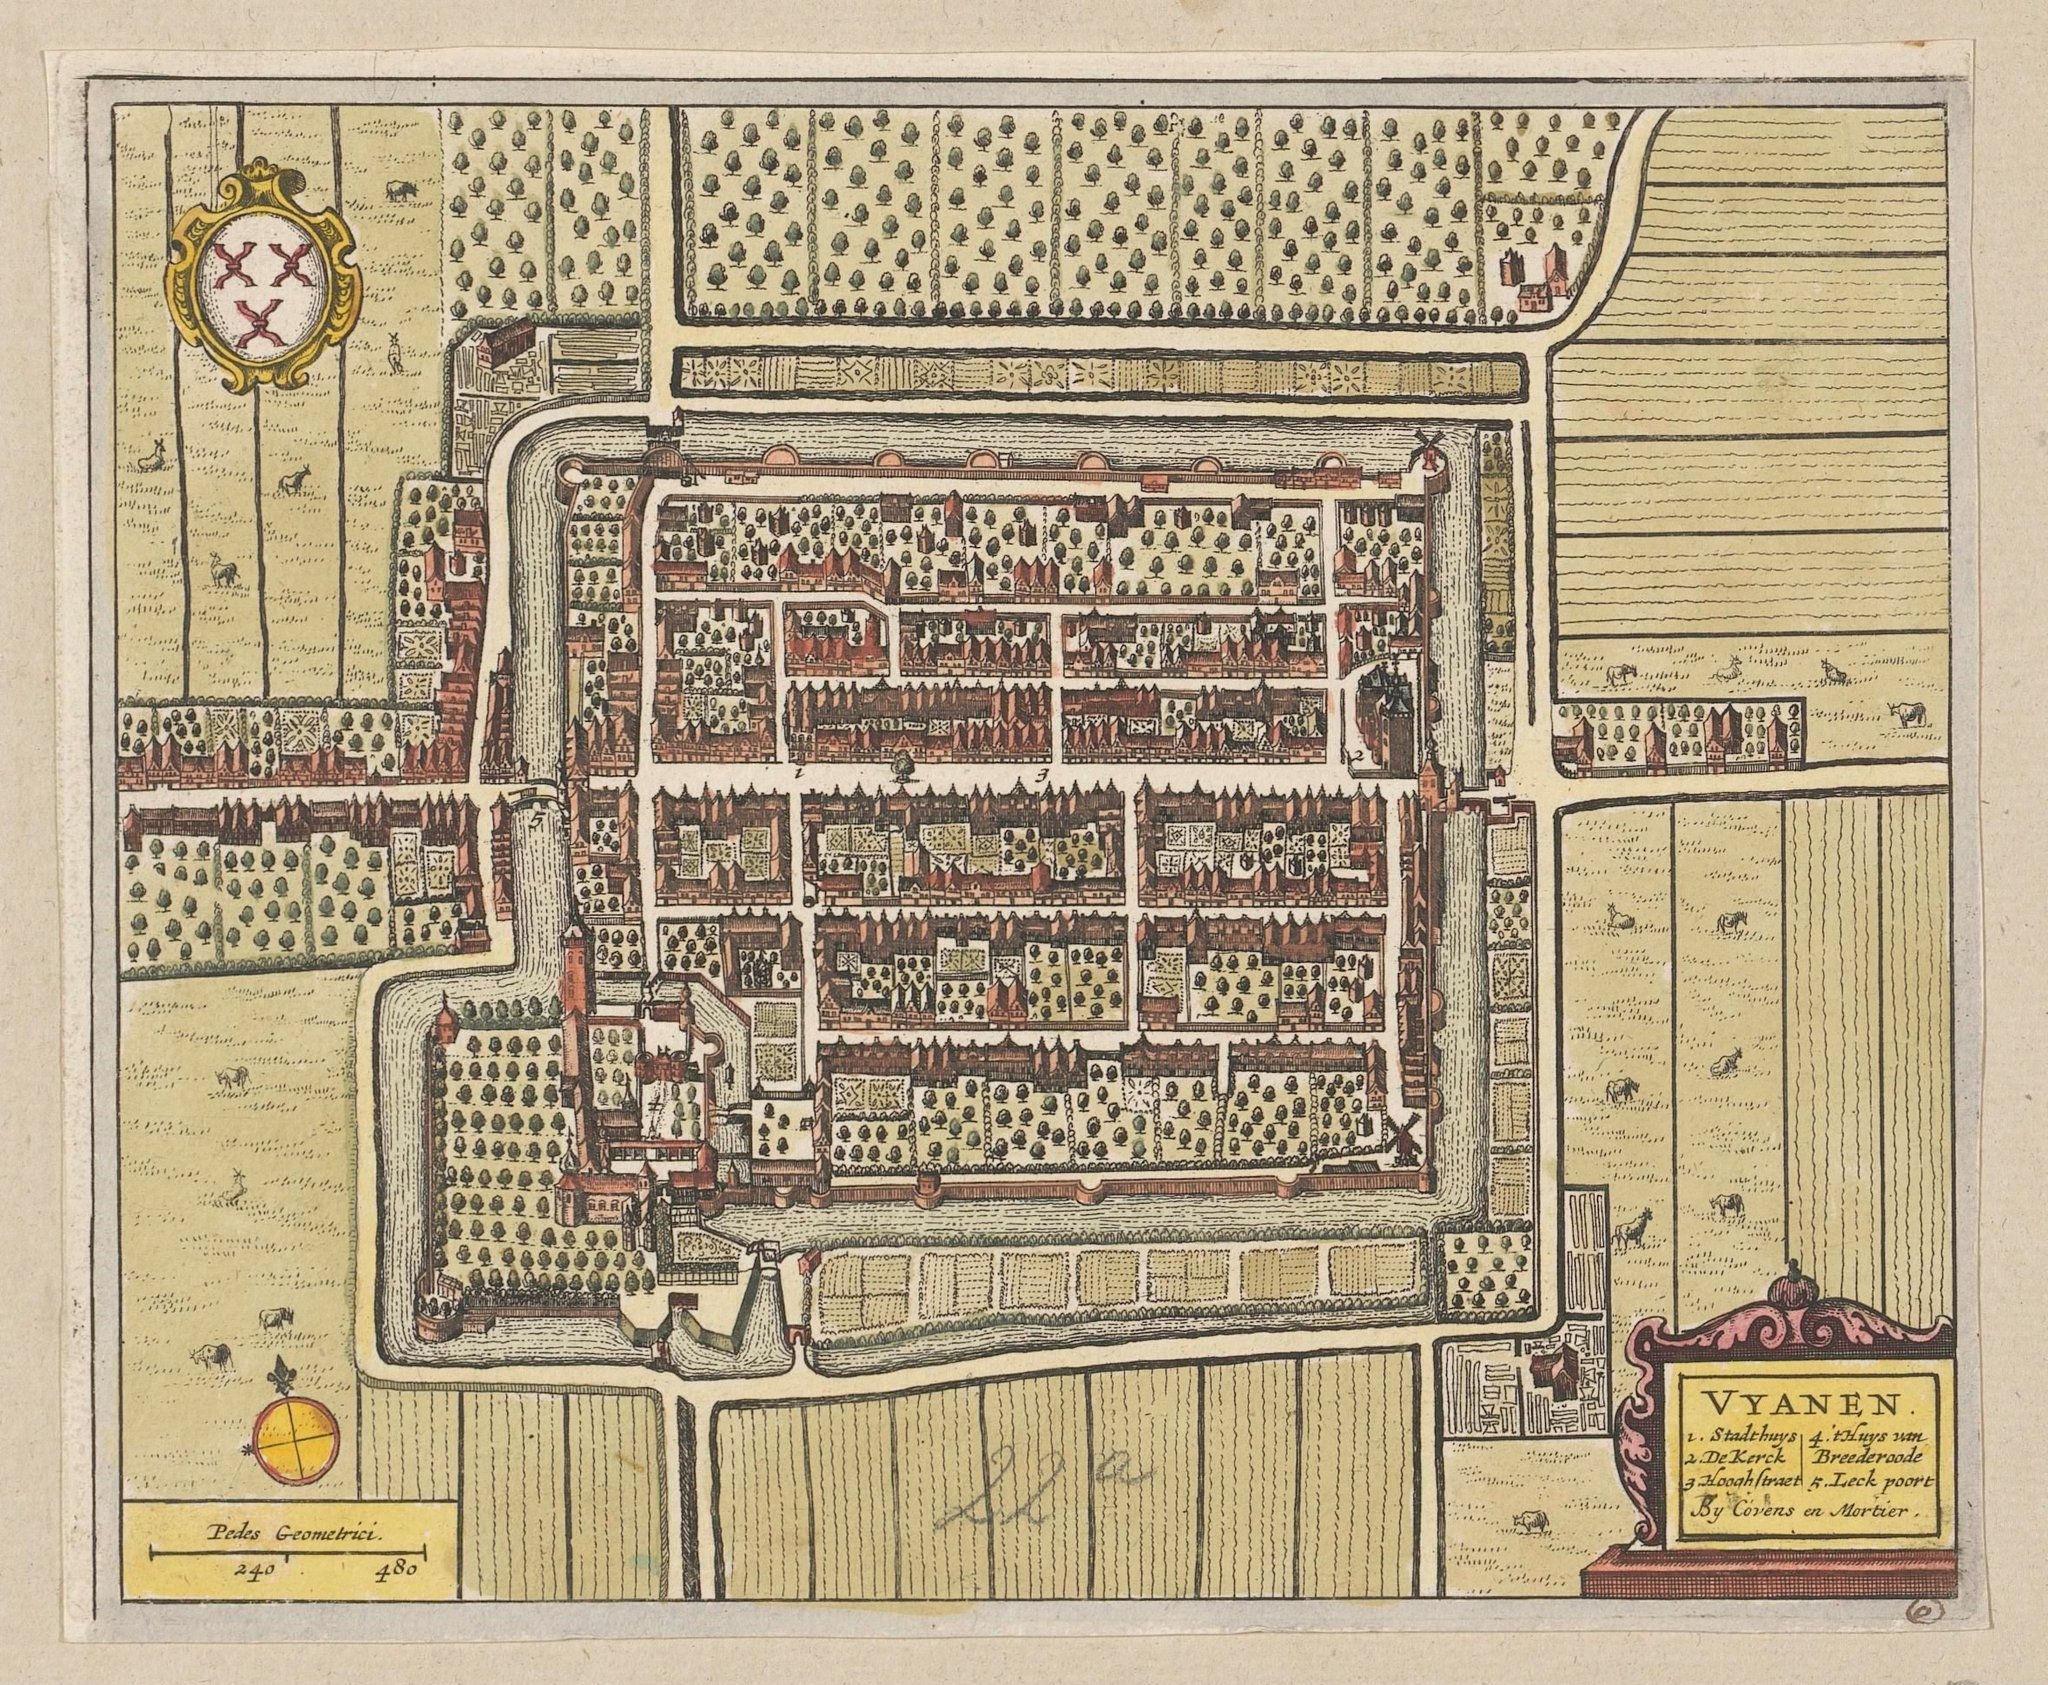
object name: print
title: Plattegrond van Vianen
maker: Anonymous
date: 1657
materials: paper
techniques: engraving, etching, hand coloring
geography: amsterdam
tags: coat of arms (as symbol of the state, etc.) (+ city; municipal), maps of cities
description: Oorspronkelijk werd deze plattegrond samen met drie andere plattegronden (van Muiden, Naarden en Weesp) gedrukt van één koperplaat. Deze prent is verschenen in 'Theatrum Urbium Celebriorum totius Belgii sive Germaniae Inferioris' (Johannes Janssonius, 1657), in 'Tooneel der vermaarste koop-steden en handelsplaatsen van de geheele wereld' (Johannes Janssonius van Waesberge (II), 1682) en in 'Teatro Belgico o vero ritratti historici, chronologici, politici e geografici delle Sette Provincie Unite' (Willem de Jonge, 1690). De plaat met deze vier plattegronden is vervolgens in het bezit van Frederik de Wit geweest en in dusdanige vorm in bepaalde drukken van zijn 'Theatrum ichnographicum omnium urbium et praecipuorum oppidorum Belgicarum XVII Provinciarum (…)' (ca. 1698-1704) verschenen. De Wit heeft de plaat versneden zodat er drie losse platen ontstonden: één met de plattegrond van Naarden, één met die van Vianen en één met de plattegronden van Muiden en Weesp. In die vorm is deze plattegrond ook verschenen in bepaalde drukken van zijn 'Theatrum ichnographicum omnium urbium et praecipuorum oppidorum Belgicarum XVII Provinciarum (…)' (ca. 1698-1704) en in zijn 'Theatrum ichnographicum omnium urbium et praecipuorum oppidorum Belgicarum XVII Provinciarum (…)' (ca. 1700-1710). Vervolgens kwam de plaat in handen van Pieter van der Aa en zodoende is deze plattegrond ook verschenen in zijn 'La galerie agreable du monde (...)' (66 delen, dl. 19, 1728). Later kwam de plaat in bezit van de firma Covens & Mortier. De huidige prent is gedrukt van de versneden plaat met de plattegrond van Vianen. Zie ook RP-P-AO-8-51-1, RP-P-AO-8-55, RP-P-AO-8-56-1 en RP-P-AO-14-22A.